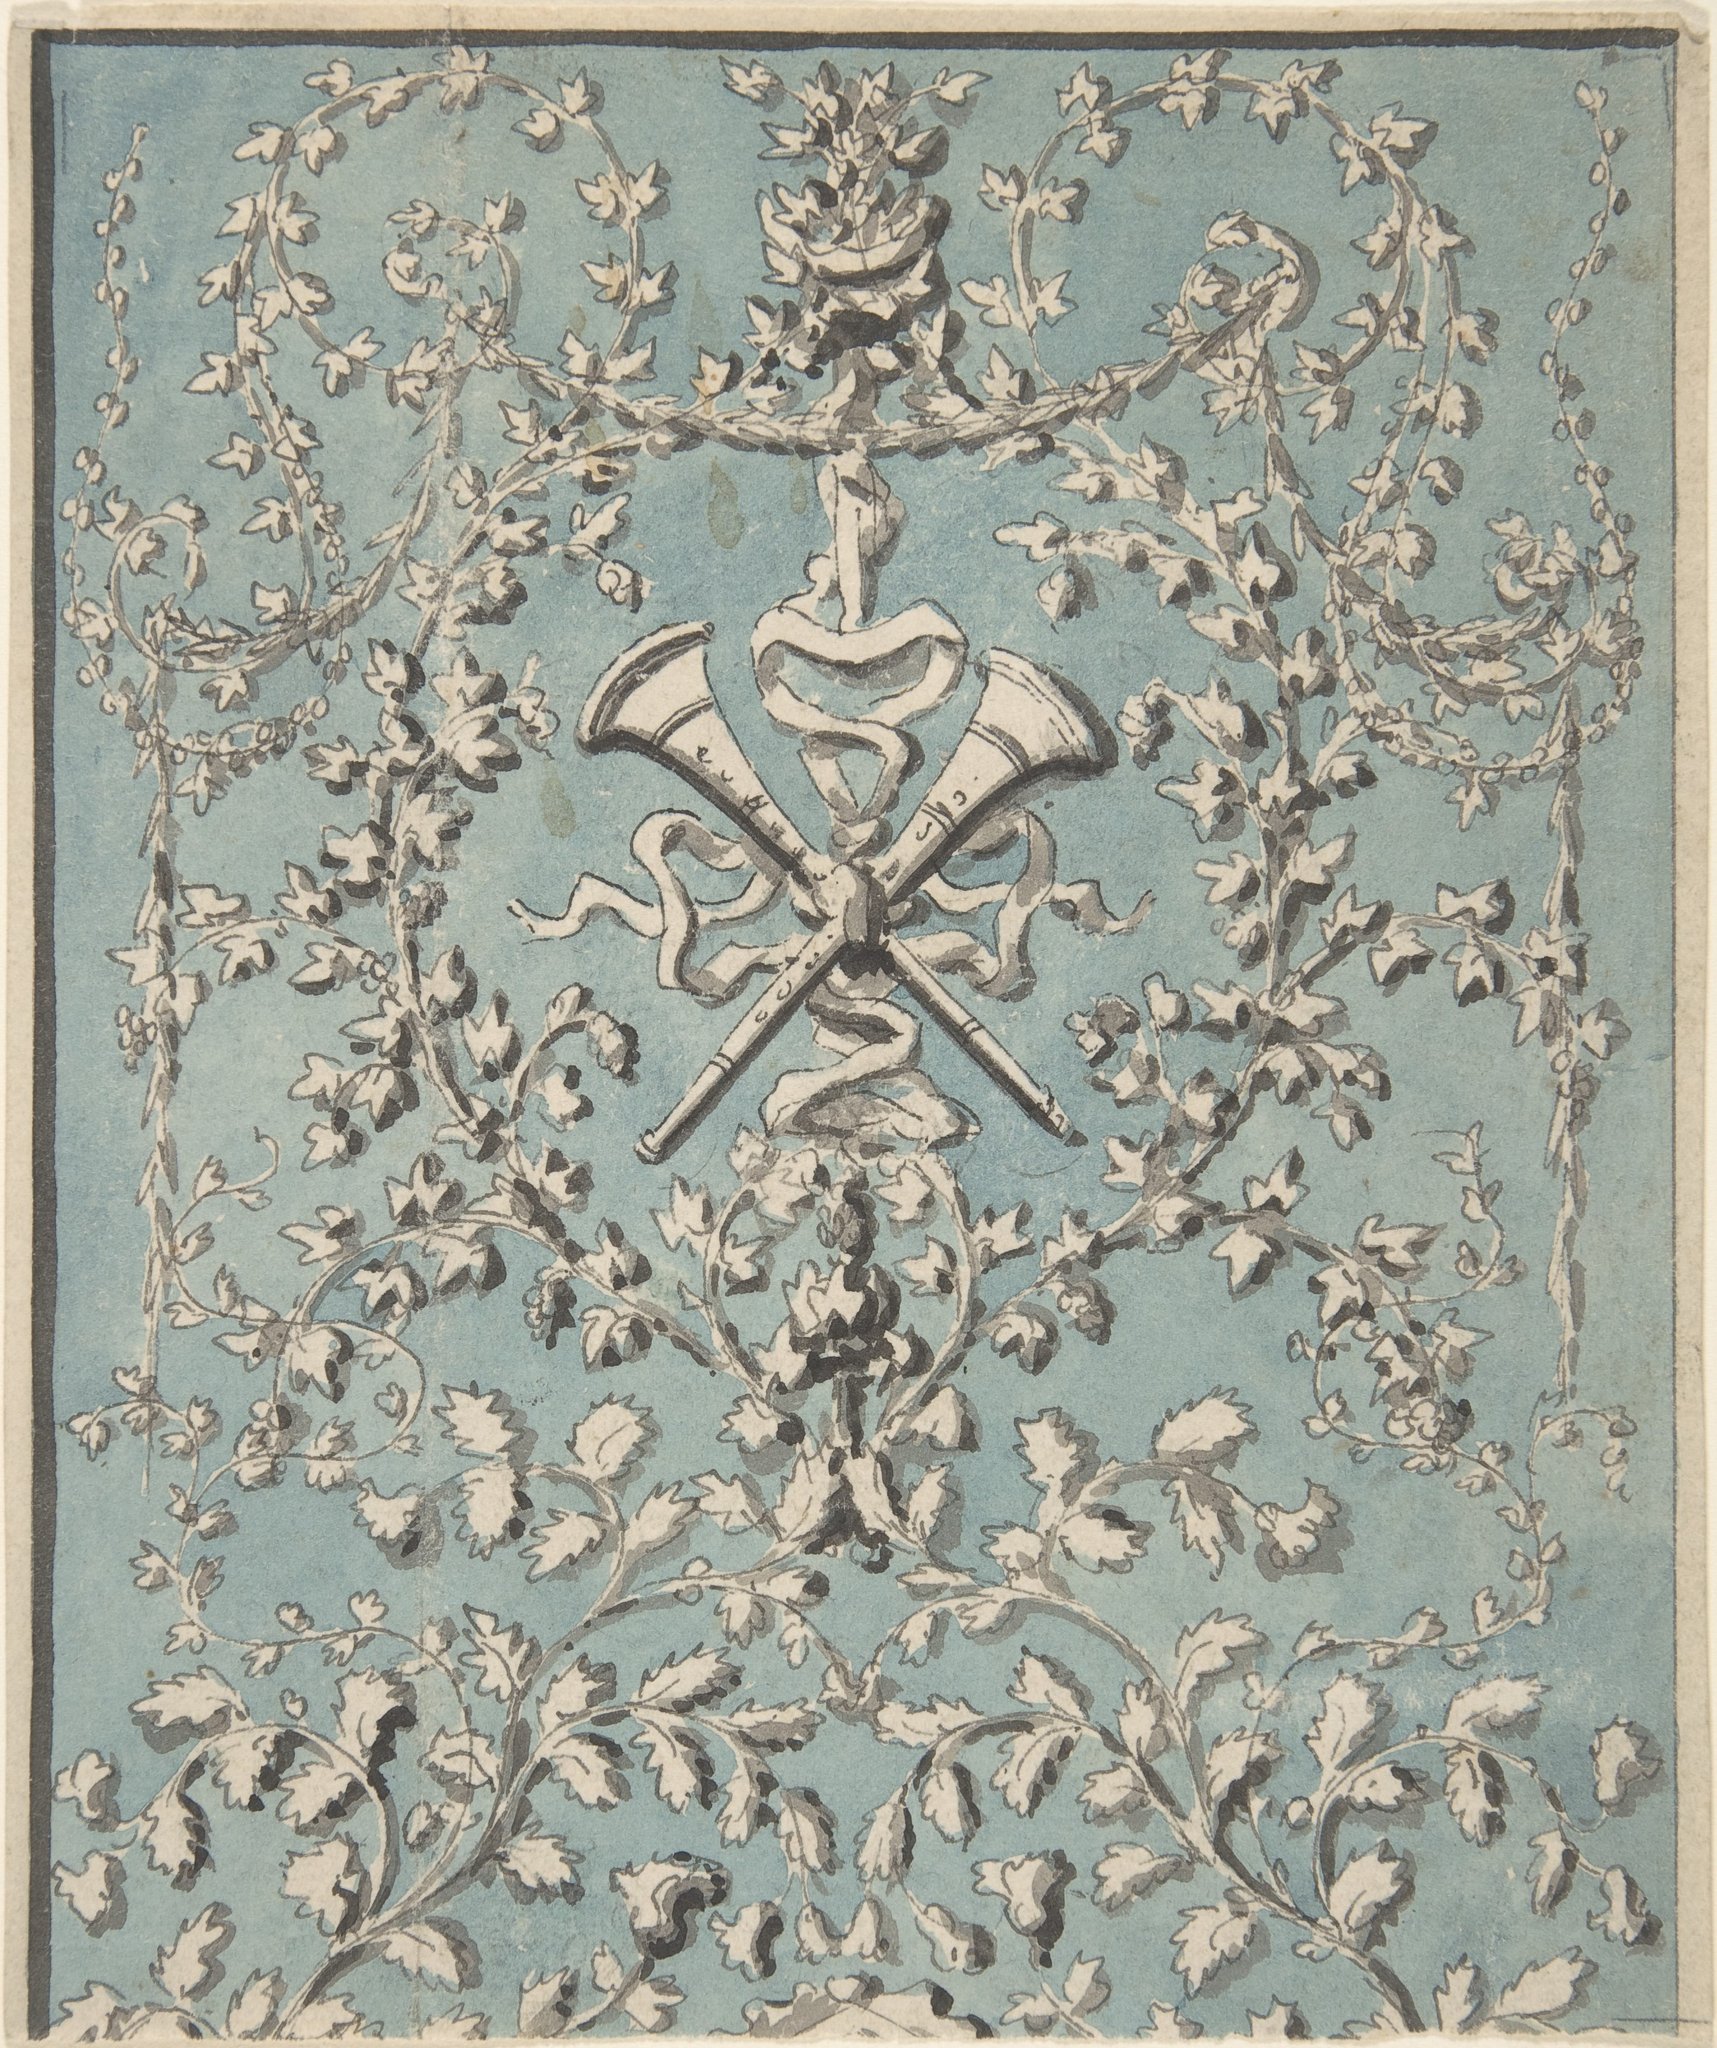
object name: drawing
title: Design for Upright Decorative Panels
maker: anonymous, french, 18th century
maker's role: artist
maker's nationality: french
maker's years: 1700-1800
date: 1701-1800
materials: ink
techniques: brush, cutting, pen, wash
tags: musical instruments,flowers,leaves